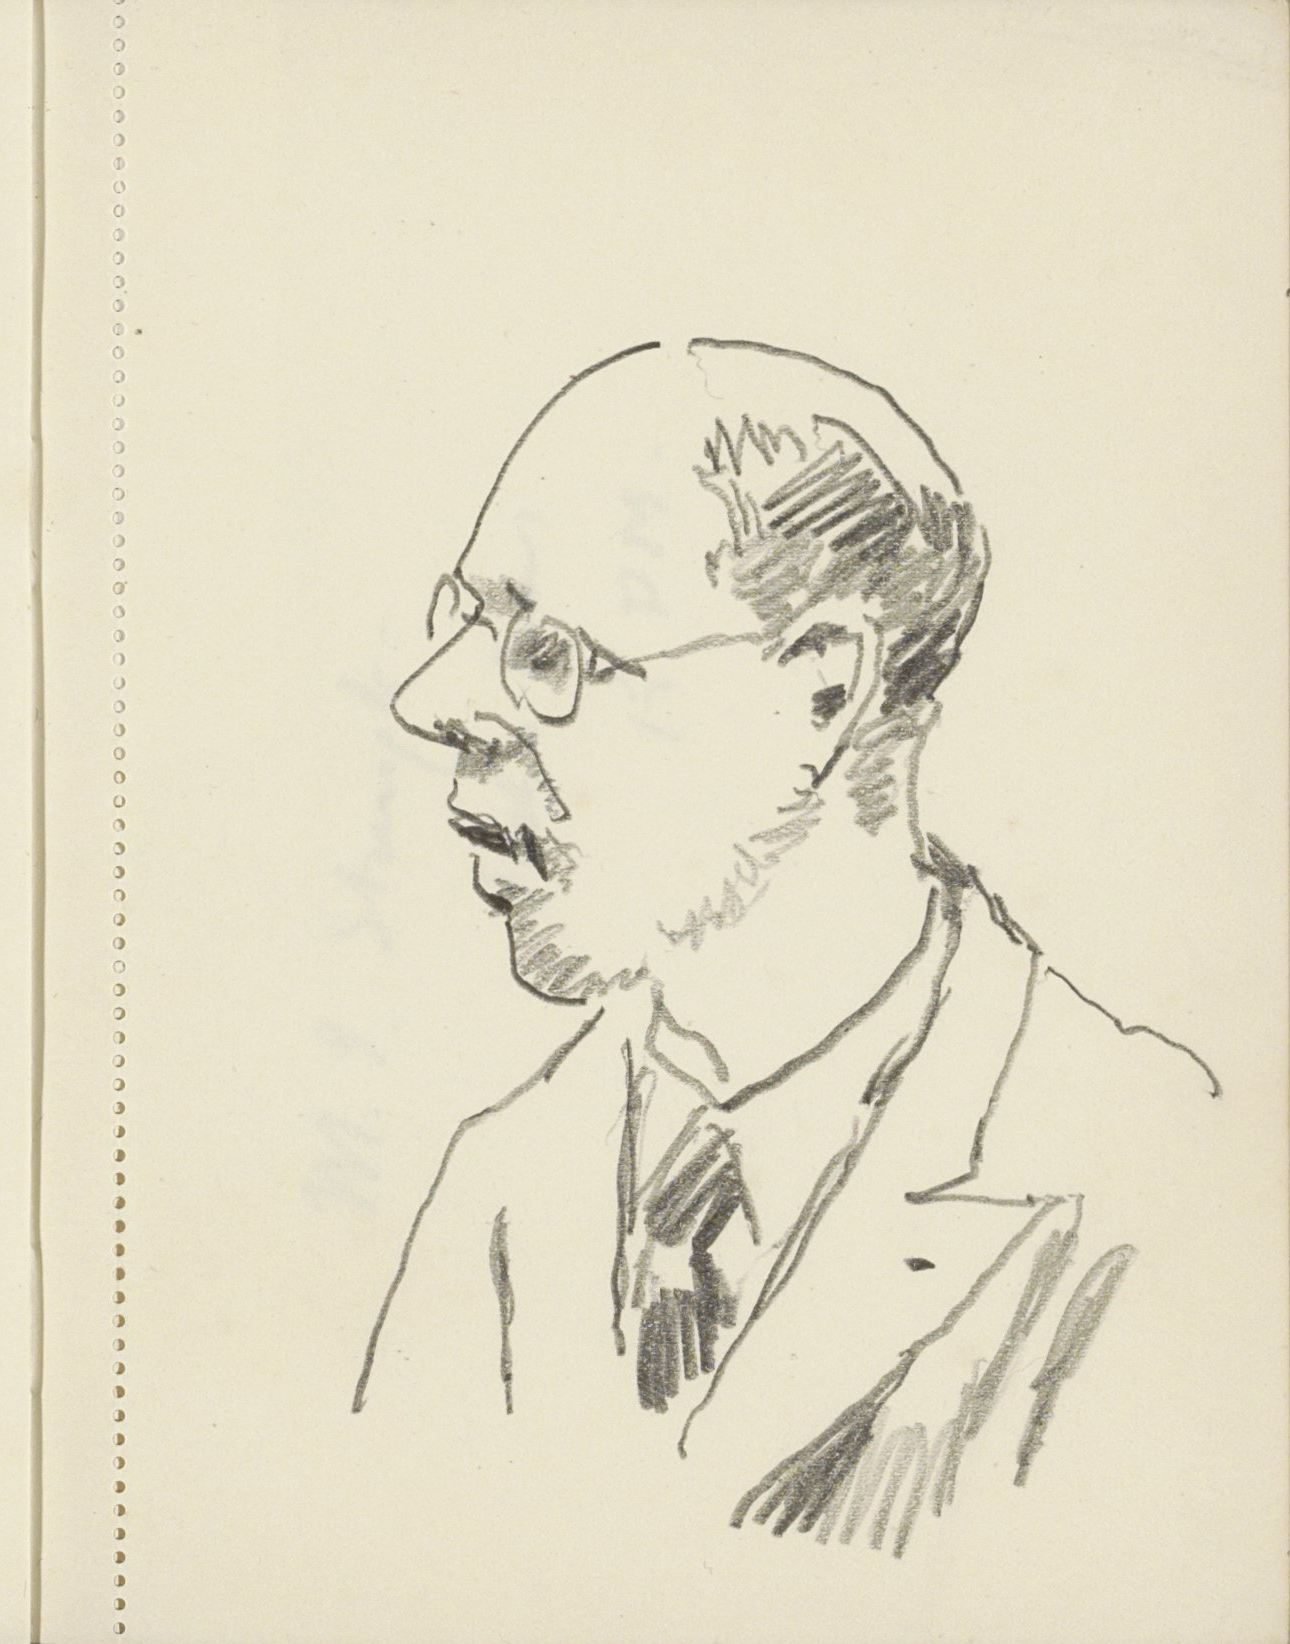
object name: sketchbook leaf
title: Portret van een man met een bril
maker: cornelis vreedenburgh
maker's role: draughtsman, print maker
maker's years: 1880-1946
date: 1890-1946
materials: paper, pencil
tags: eyeglasses, spectacles, adult man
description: De man draagt een colbert en stropdas. Blad 34 recto uit een schetsboek met 71 bladen.